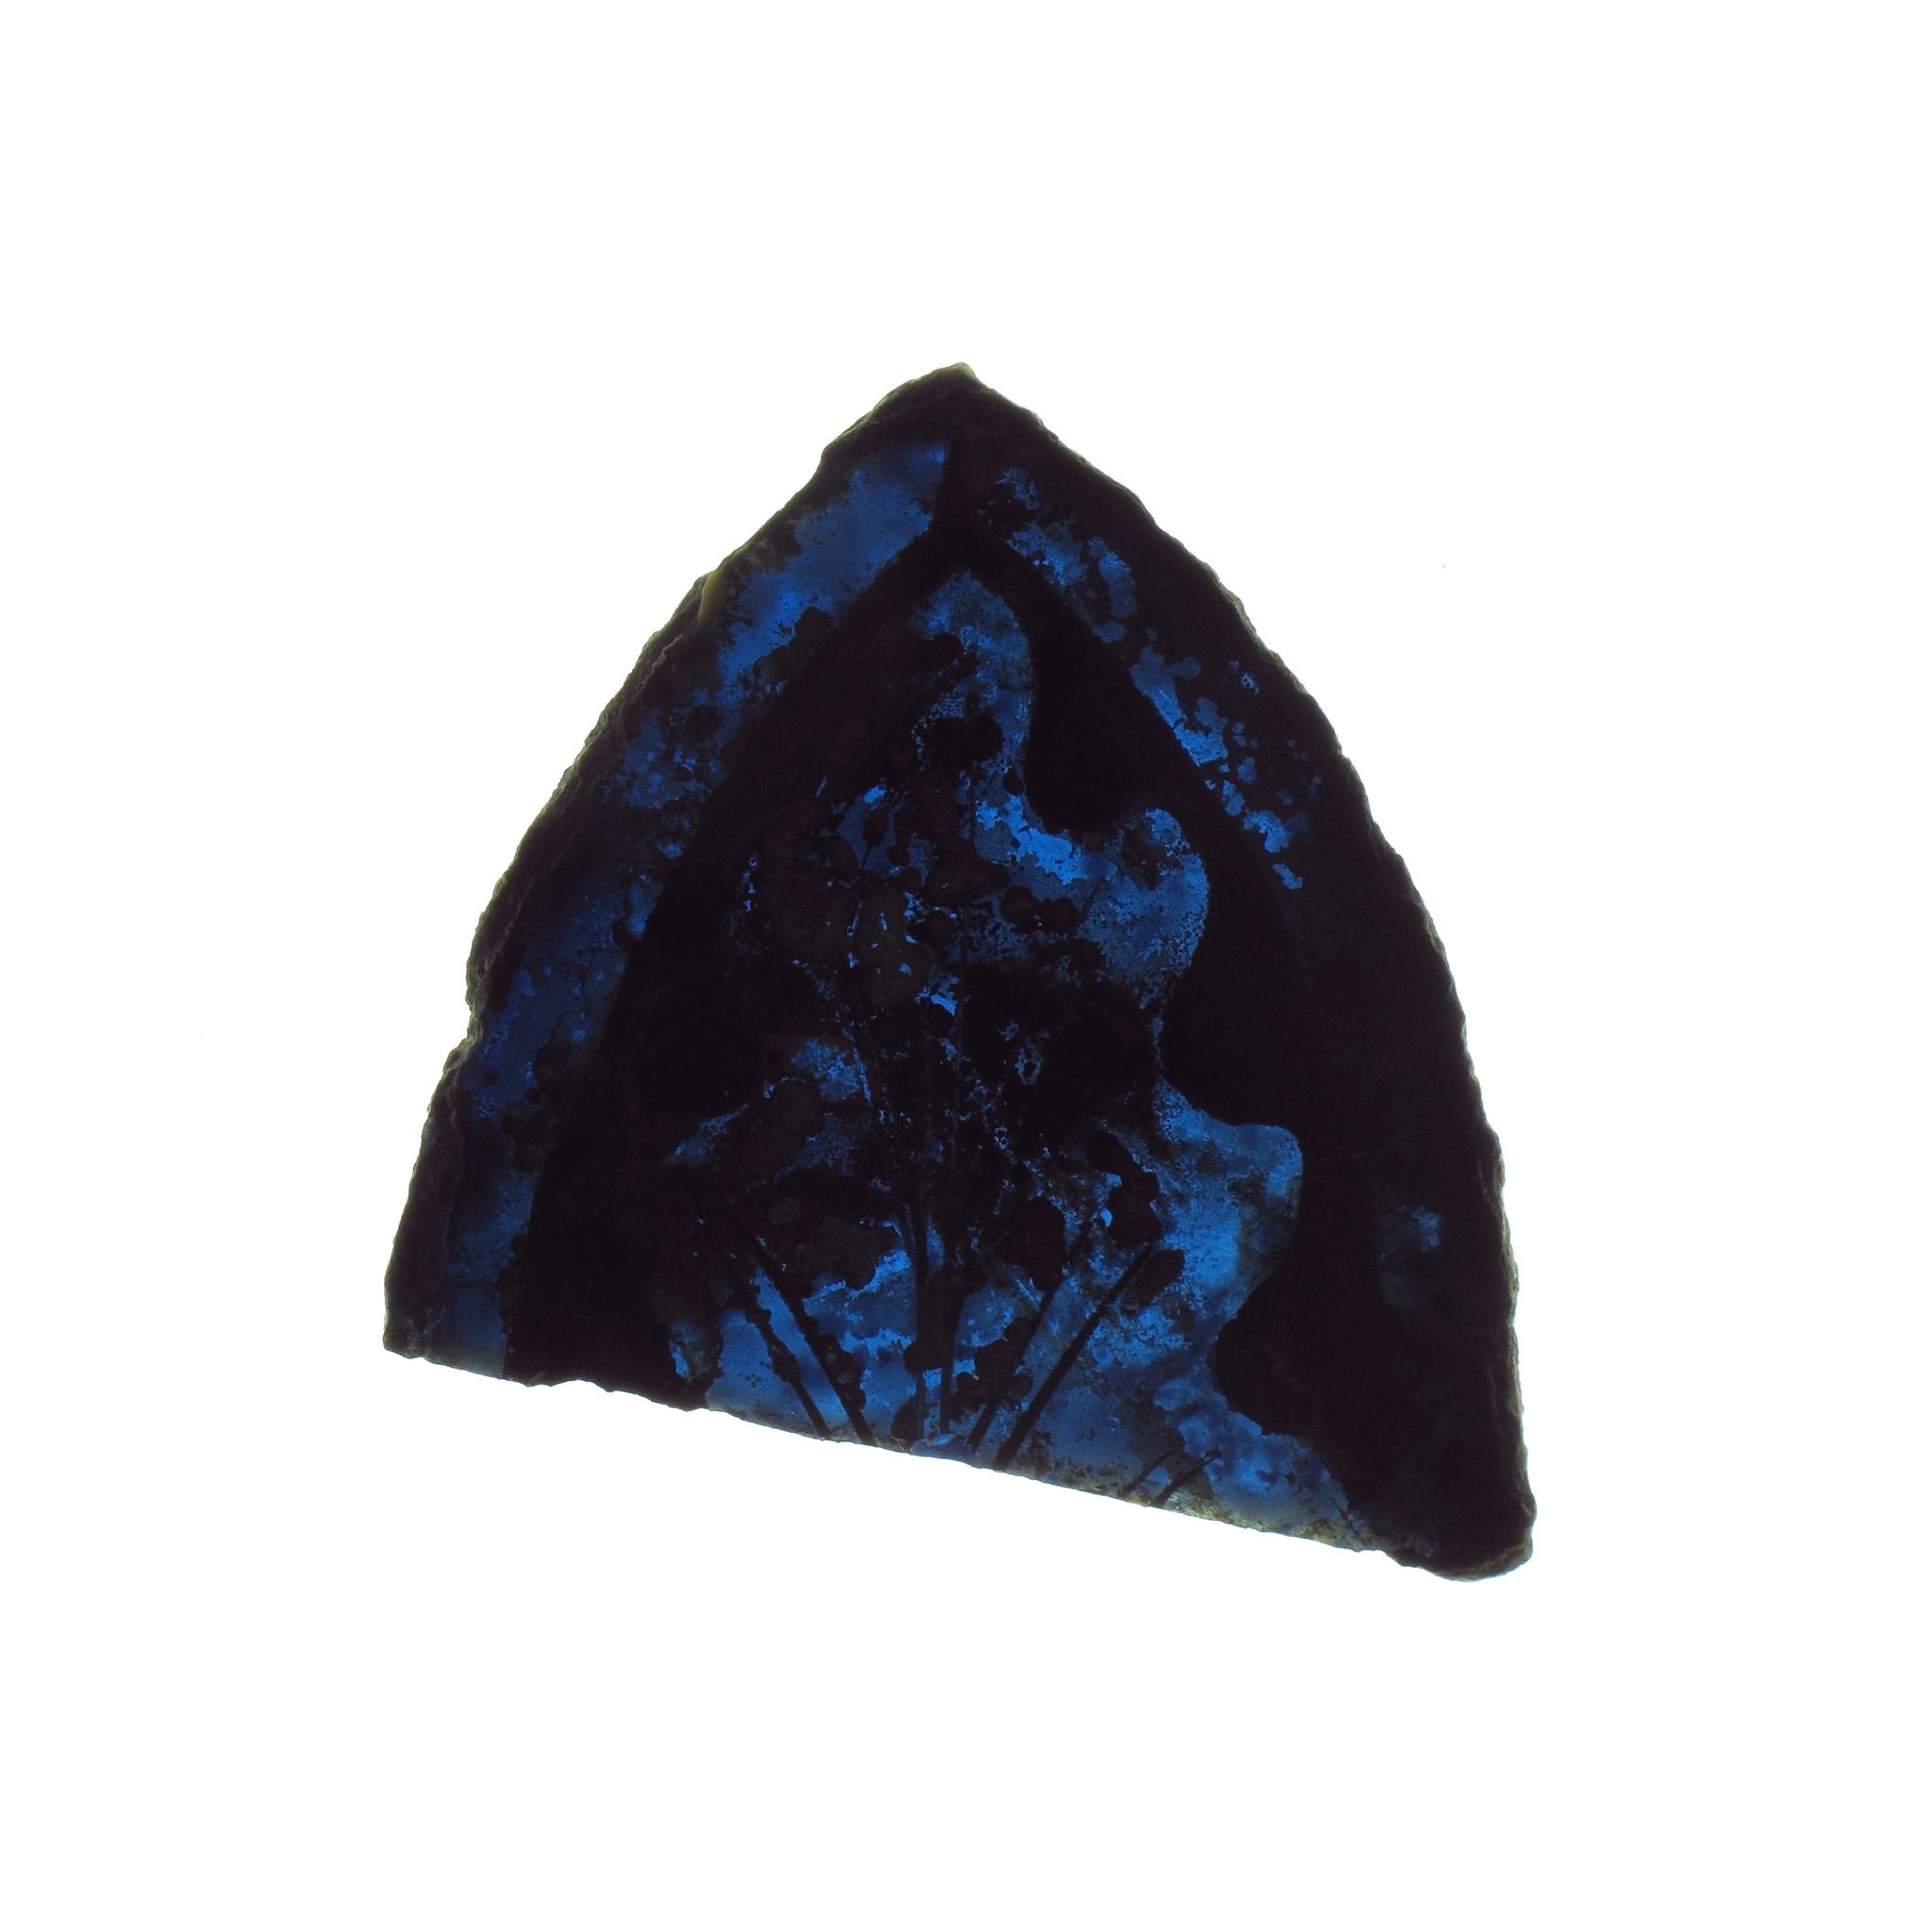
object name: fragment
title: Glass Fragment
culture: european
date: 1201-1400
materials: glass, metal